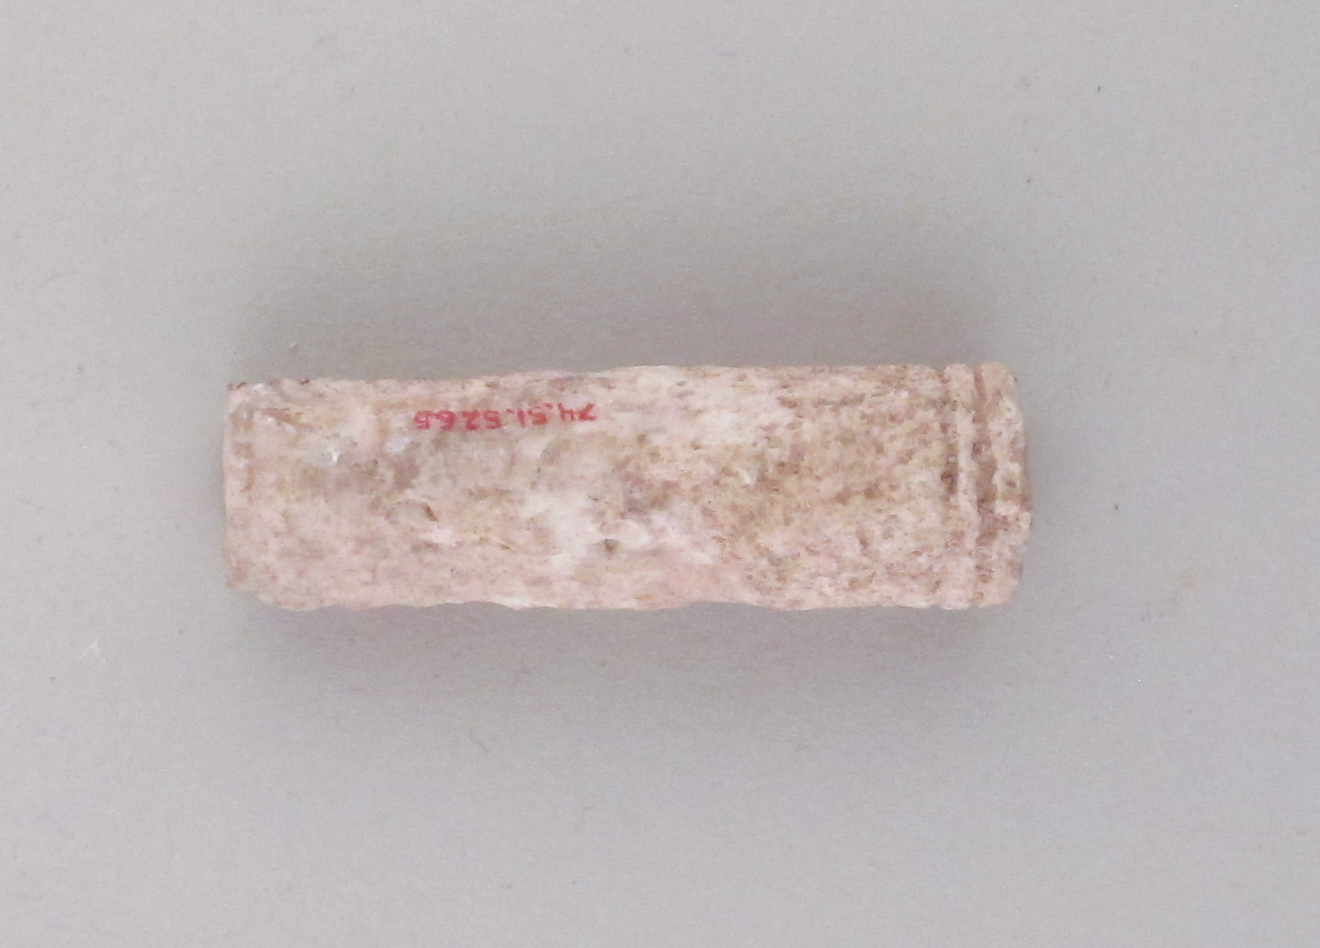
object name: handle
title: Part of an ivory spindle staff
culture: cypriot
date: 1300-1101 BCE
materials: ivory